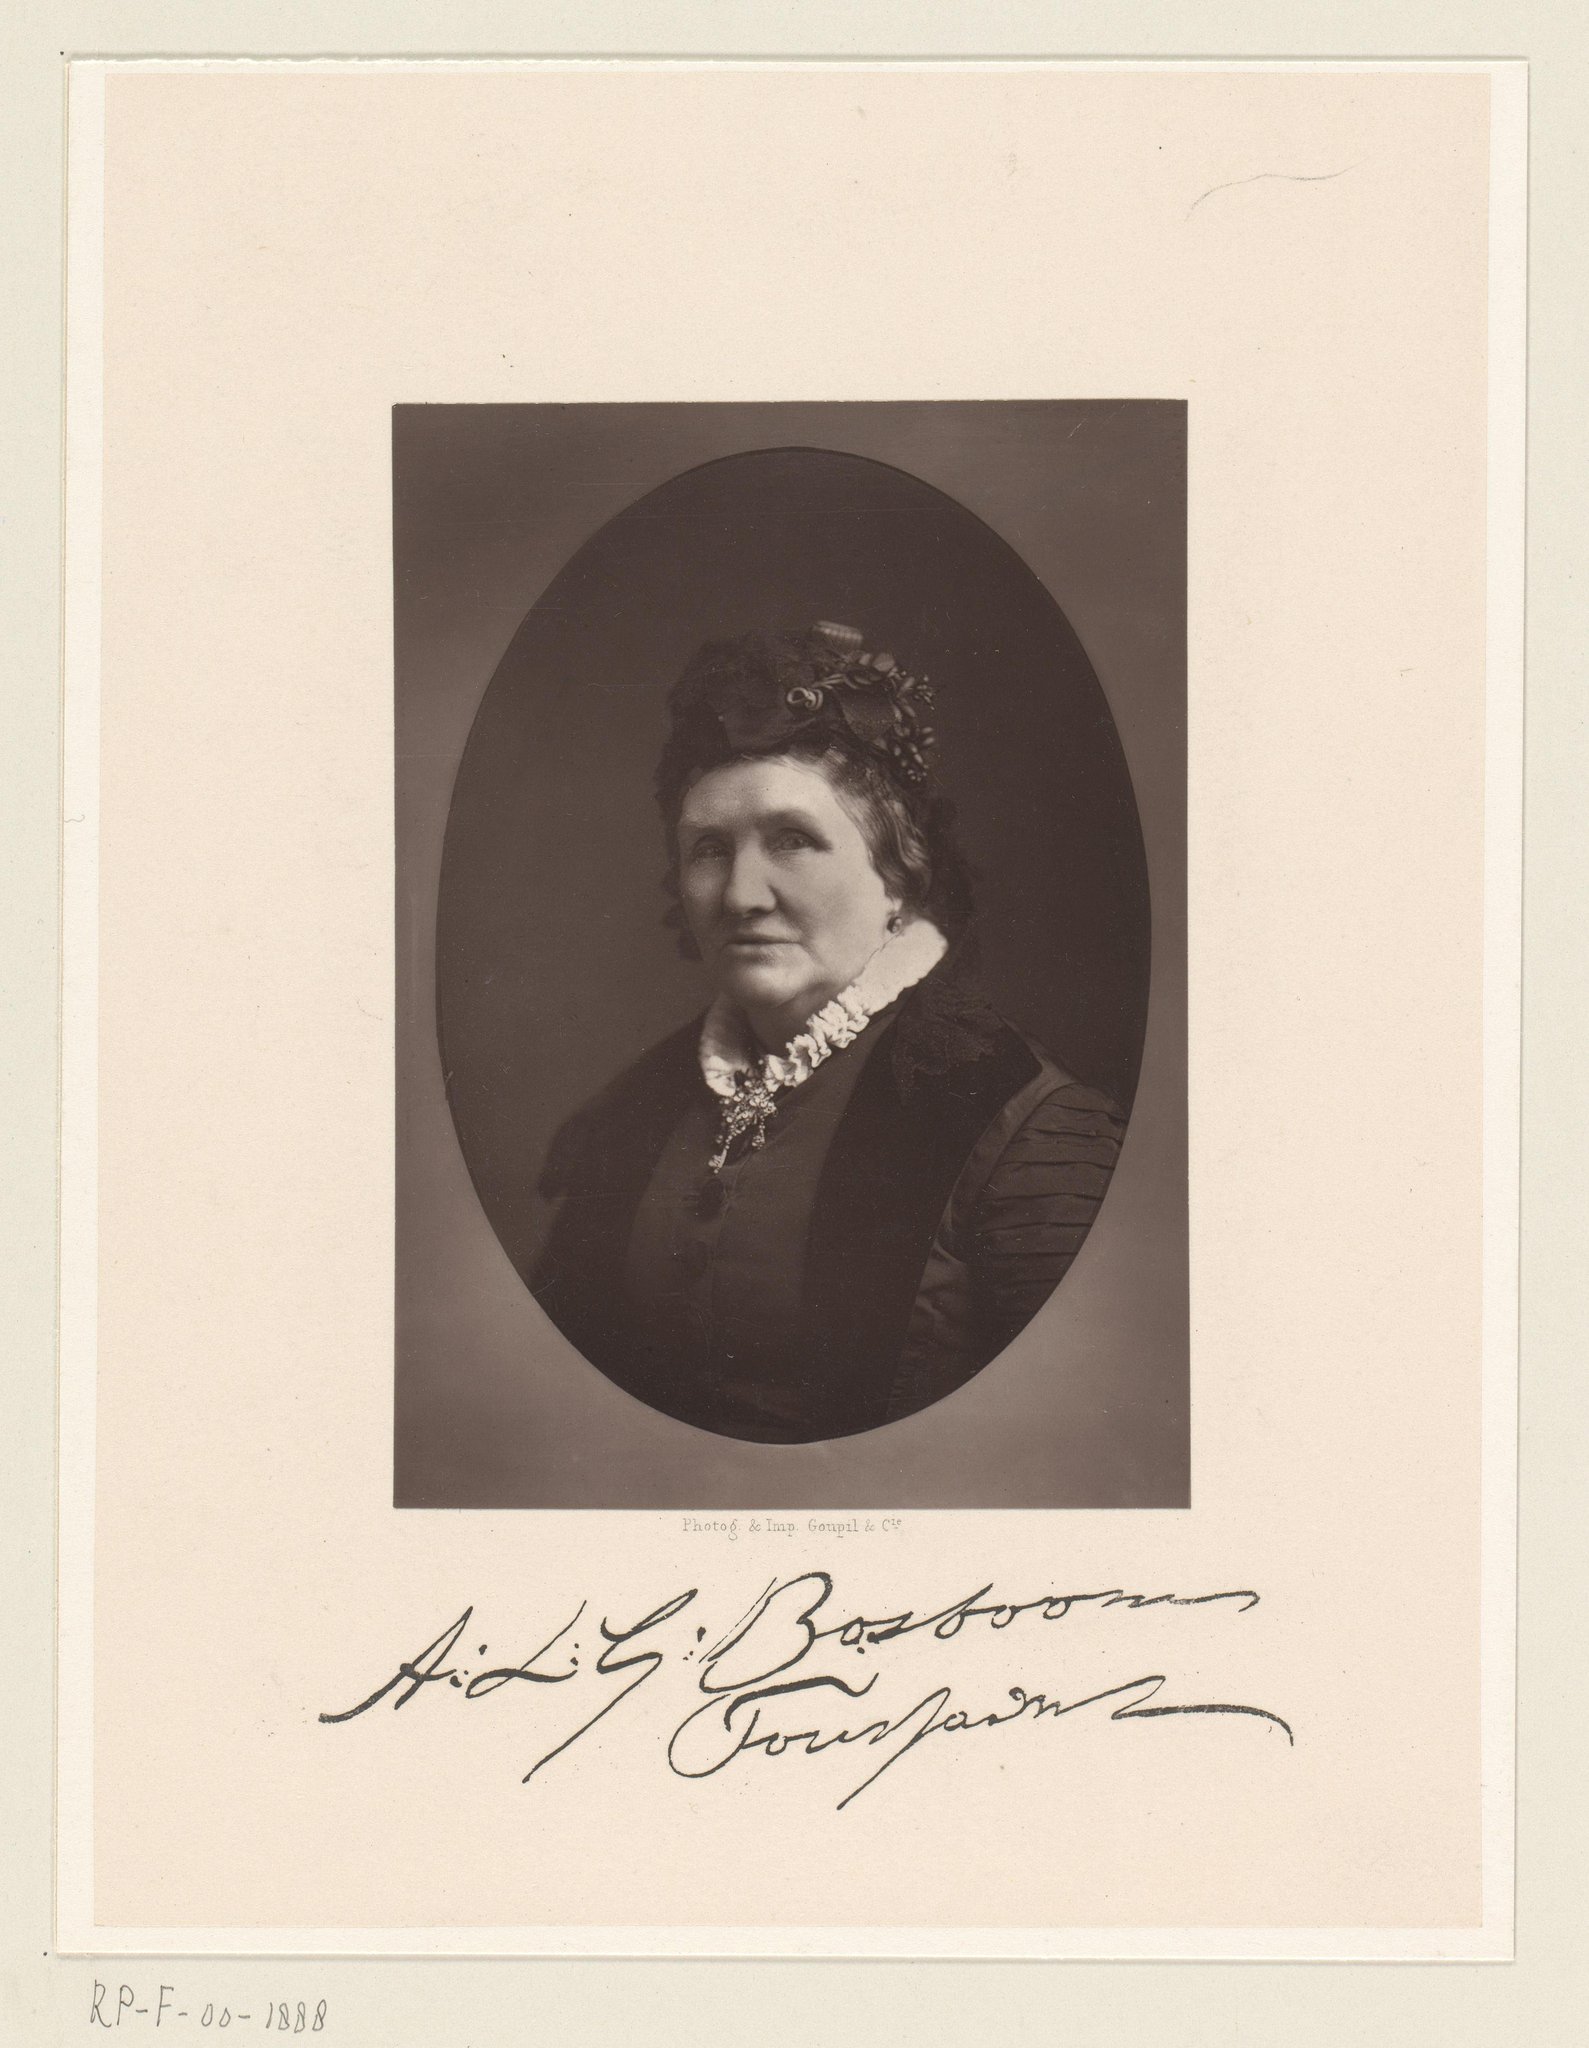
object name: photomechanical print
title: Portret van A.L.G. Bosboom-Toussaint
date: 1880-1885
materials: cardboard, paper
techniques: woodburytype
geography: the hague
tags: the hague, anna louisa geertruyda bosboom-toussaint, historical persons, writer, poet, author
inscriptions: signature: ‘A:L:G: Bosboom/ Toussaint’